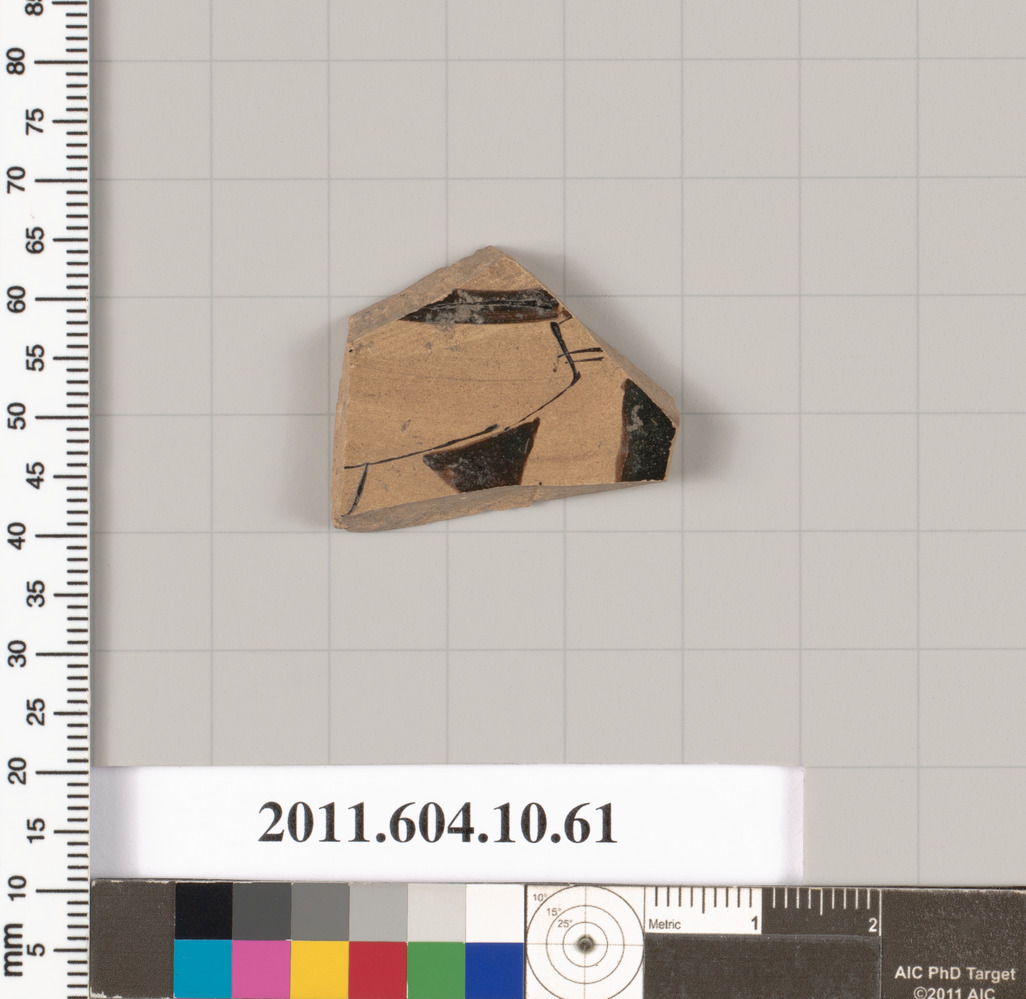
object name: kylix fragment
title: Terracotta fragment of a kylix (drinking cup)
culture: etruscan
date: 334-301 BCE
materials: terracotta